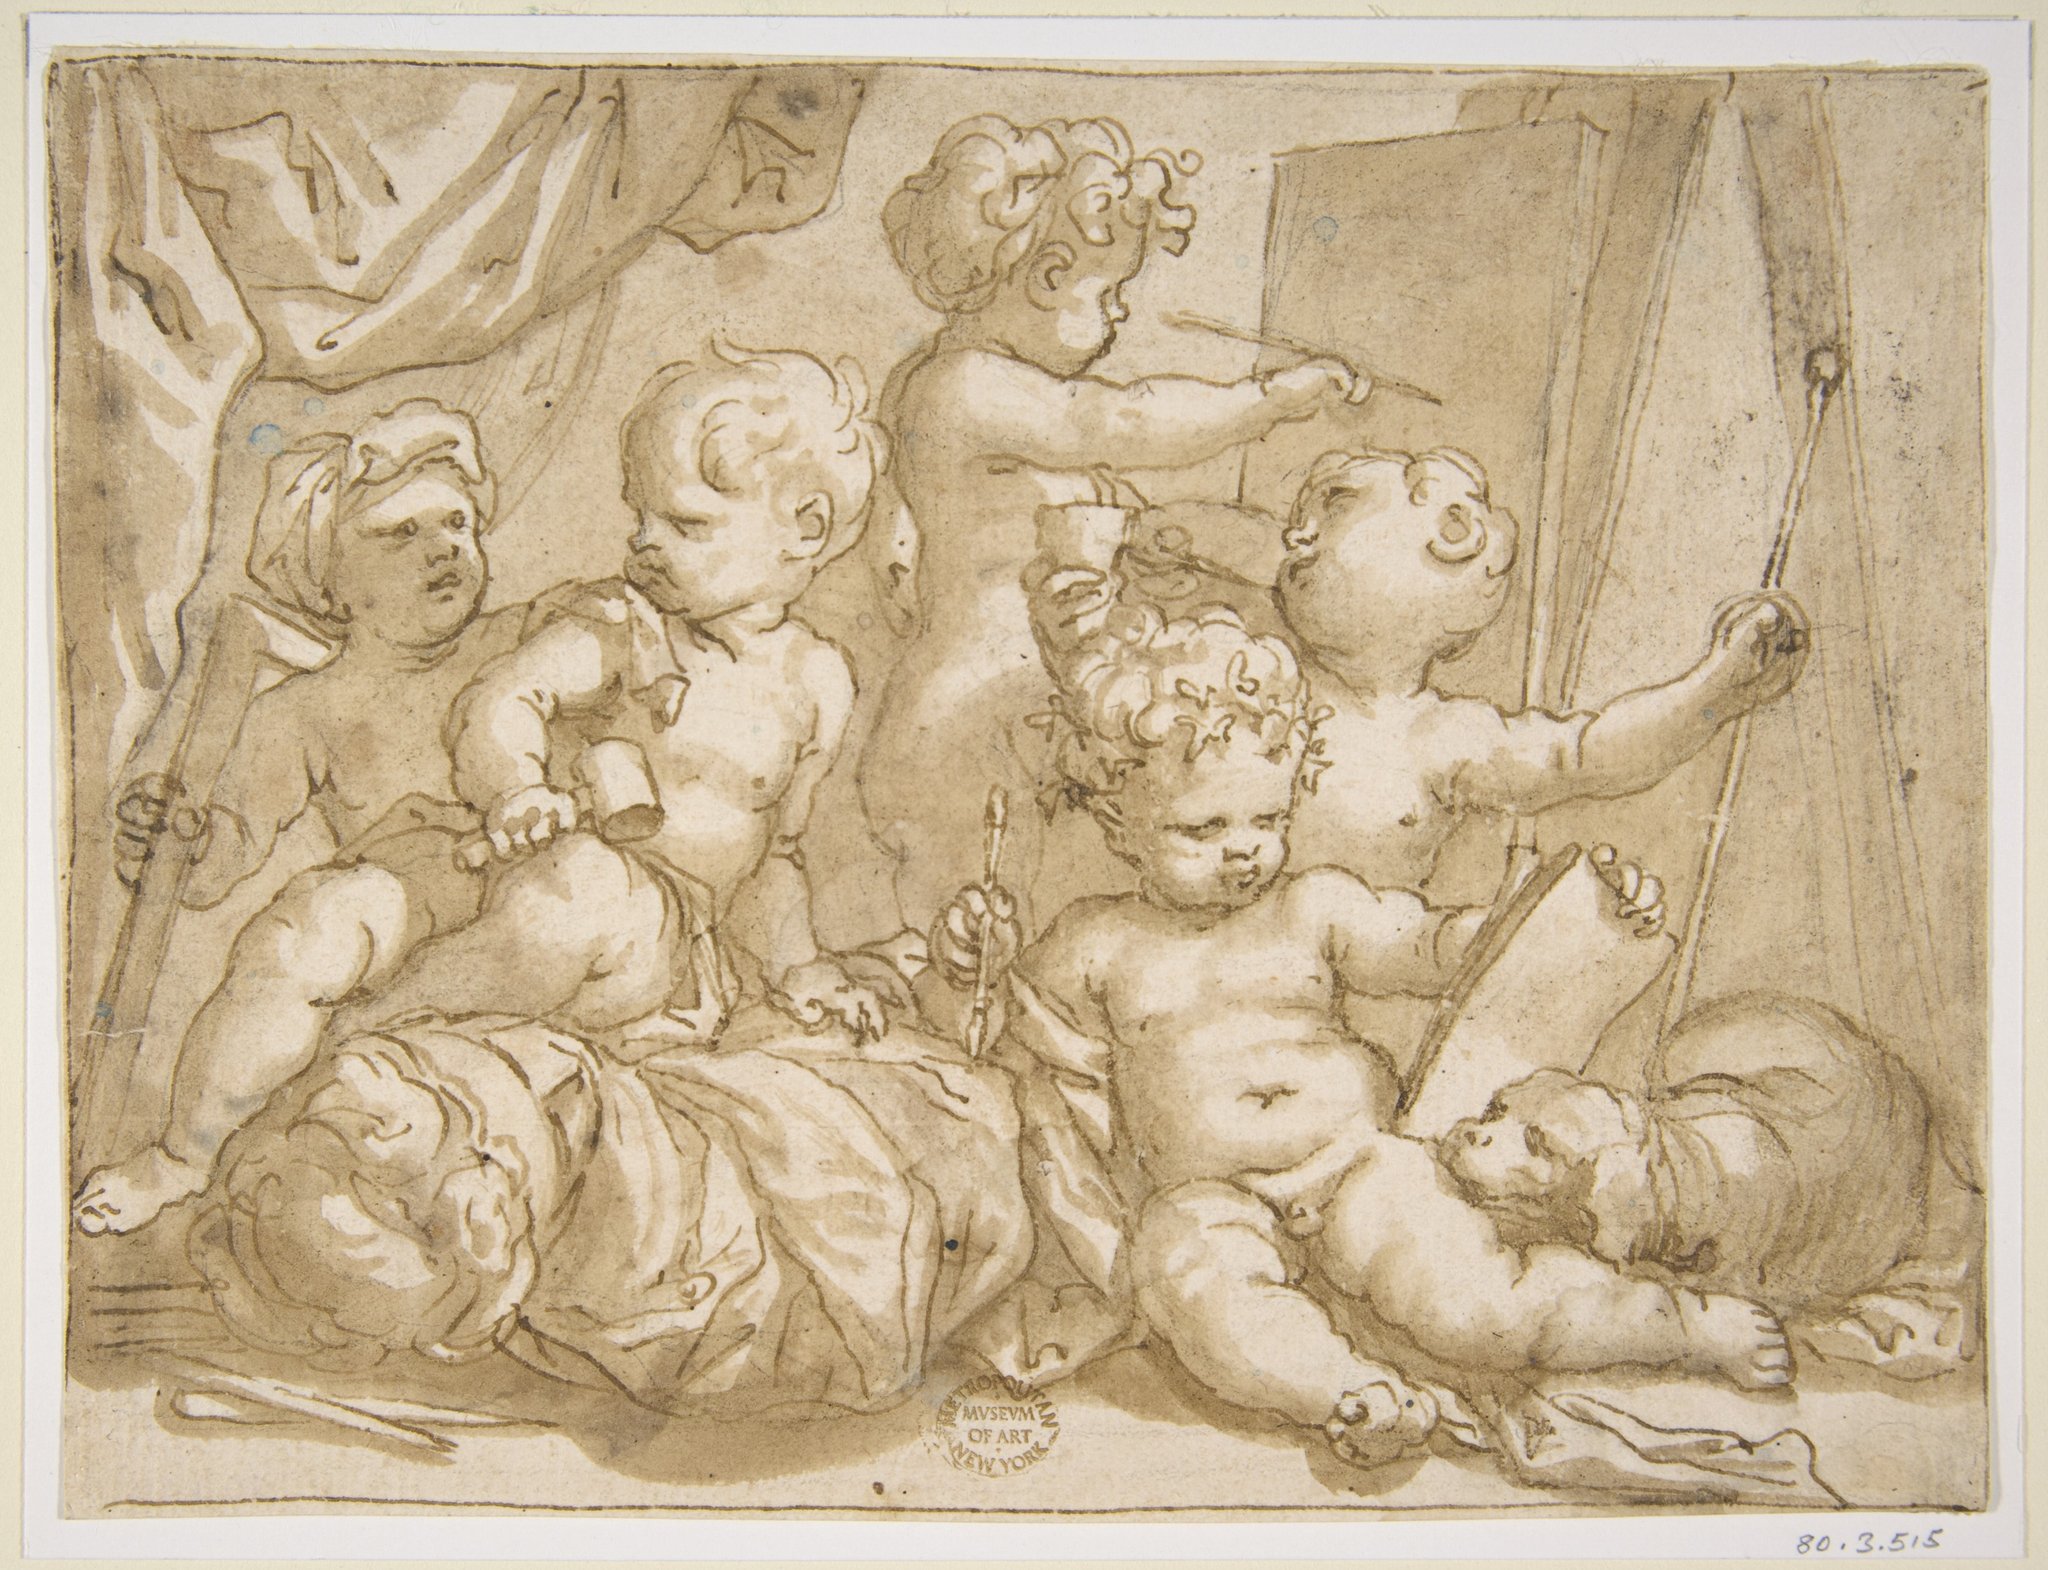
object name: drawing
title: Putti with the Attributes of the Arts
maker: domenico piola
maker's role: artist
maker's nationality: italian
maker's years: 1627-1703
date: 1627-1703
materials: charcoal, ink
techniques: brush, pen, wash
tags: putti,dogs